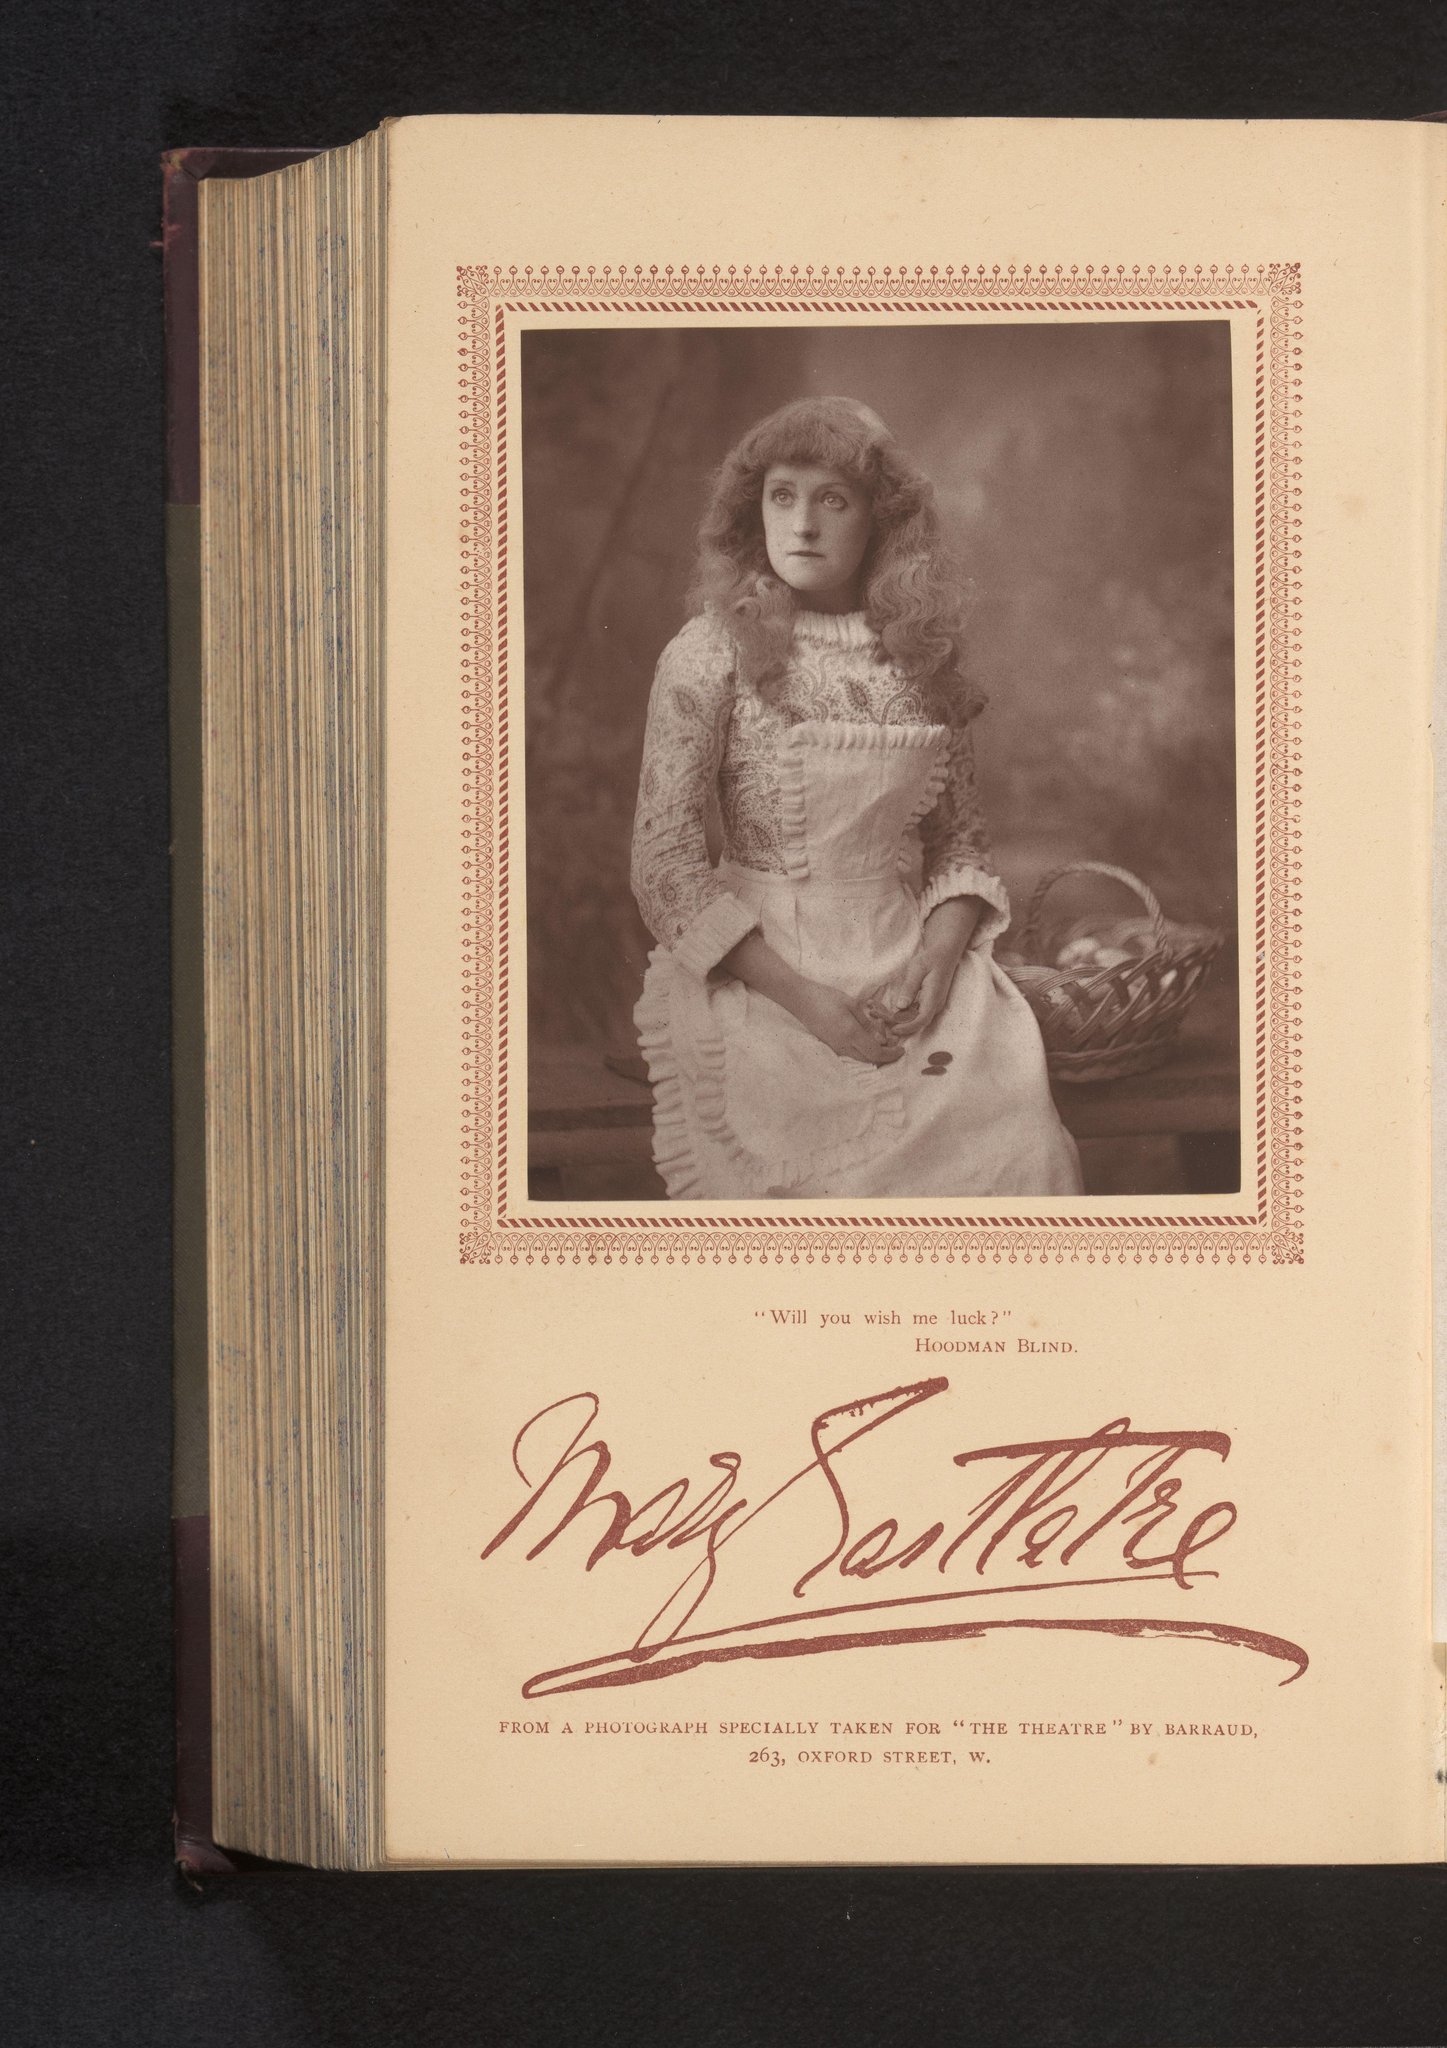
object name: page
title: Portret van een onbekende vrouw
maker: herbert rose barraud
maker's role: fotograaf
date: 1880-1885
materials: paper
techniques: woodburytype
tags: adult woman, historical persons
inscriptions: signature: ‘[...]’, inscription: ‘'Will you wish me luck?'/ Hoodman Blind’